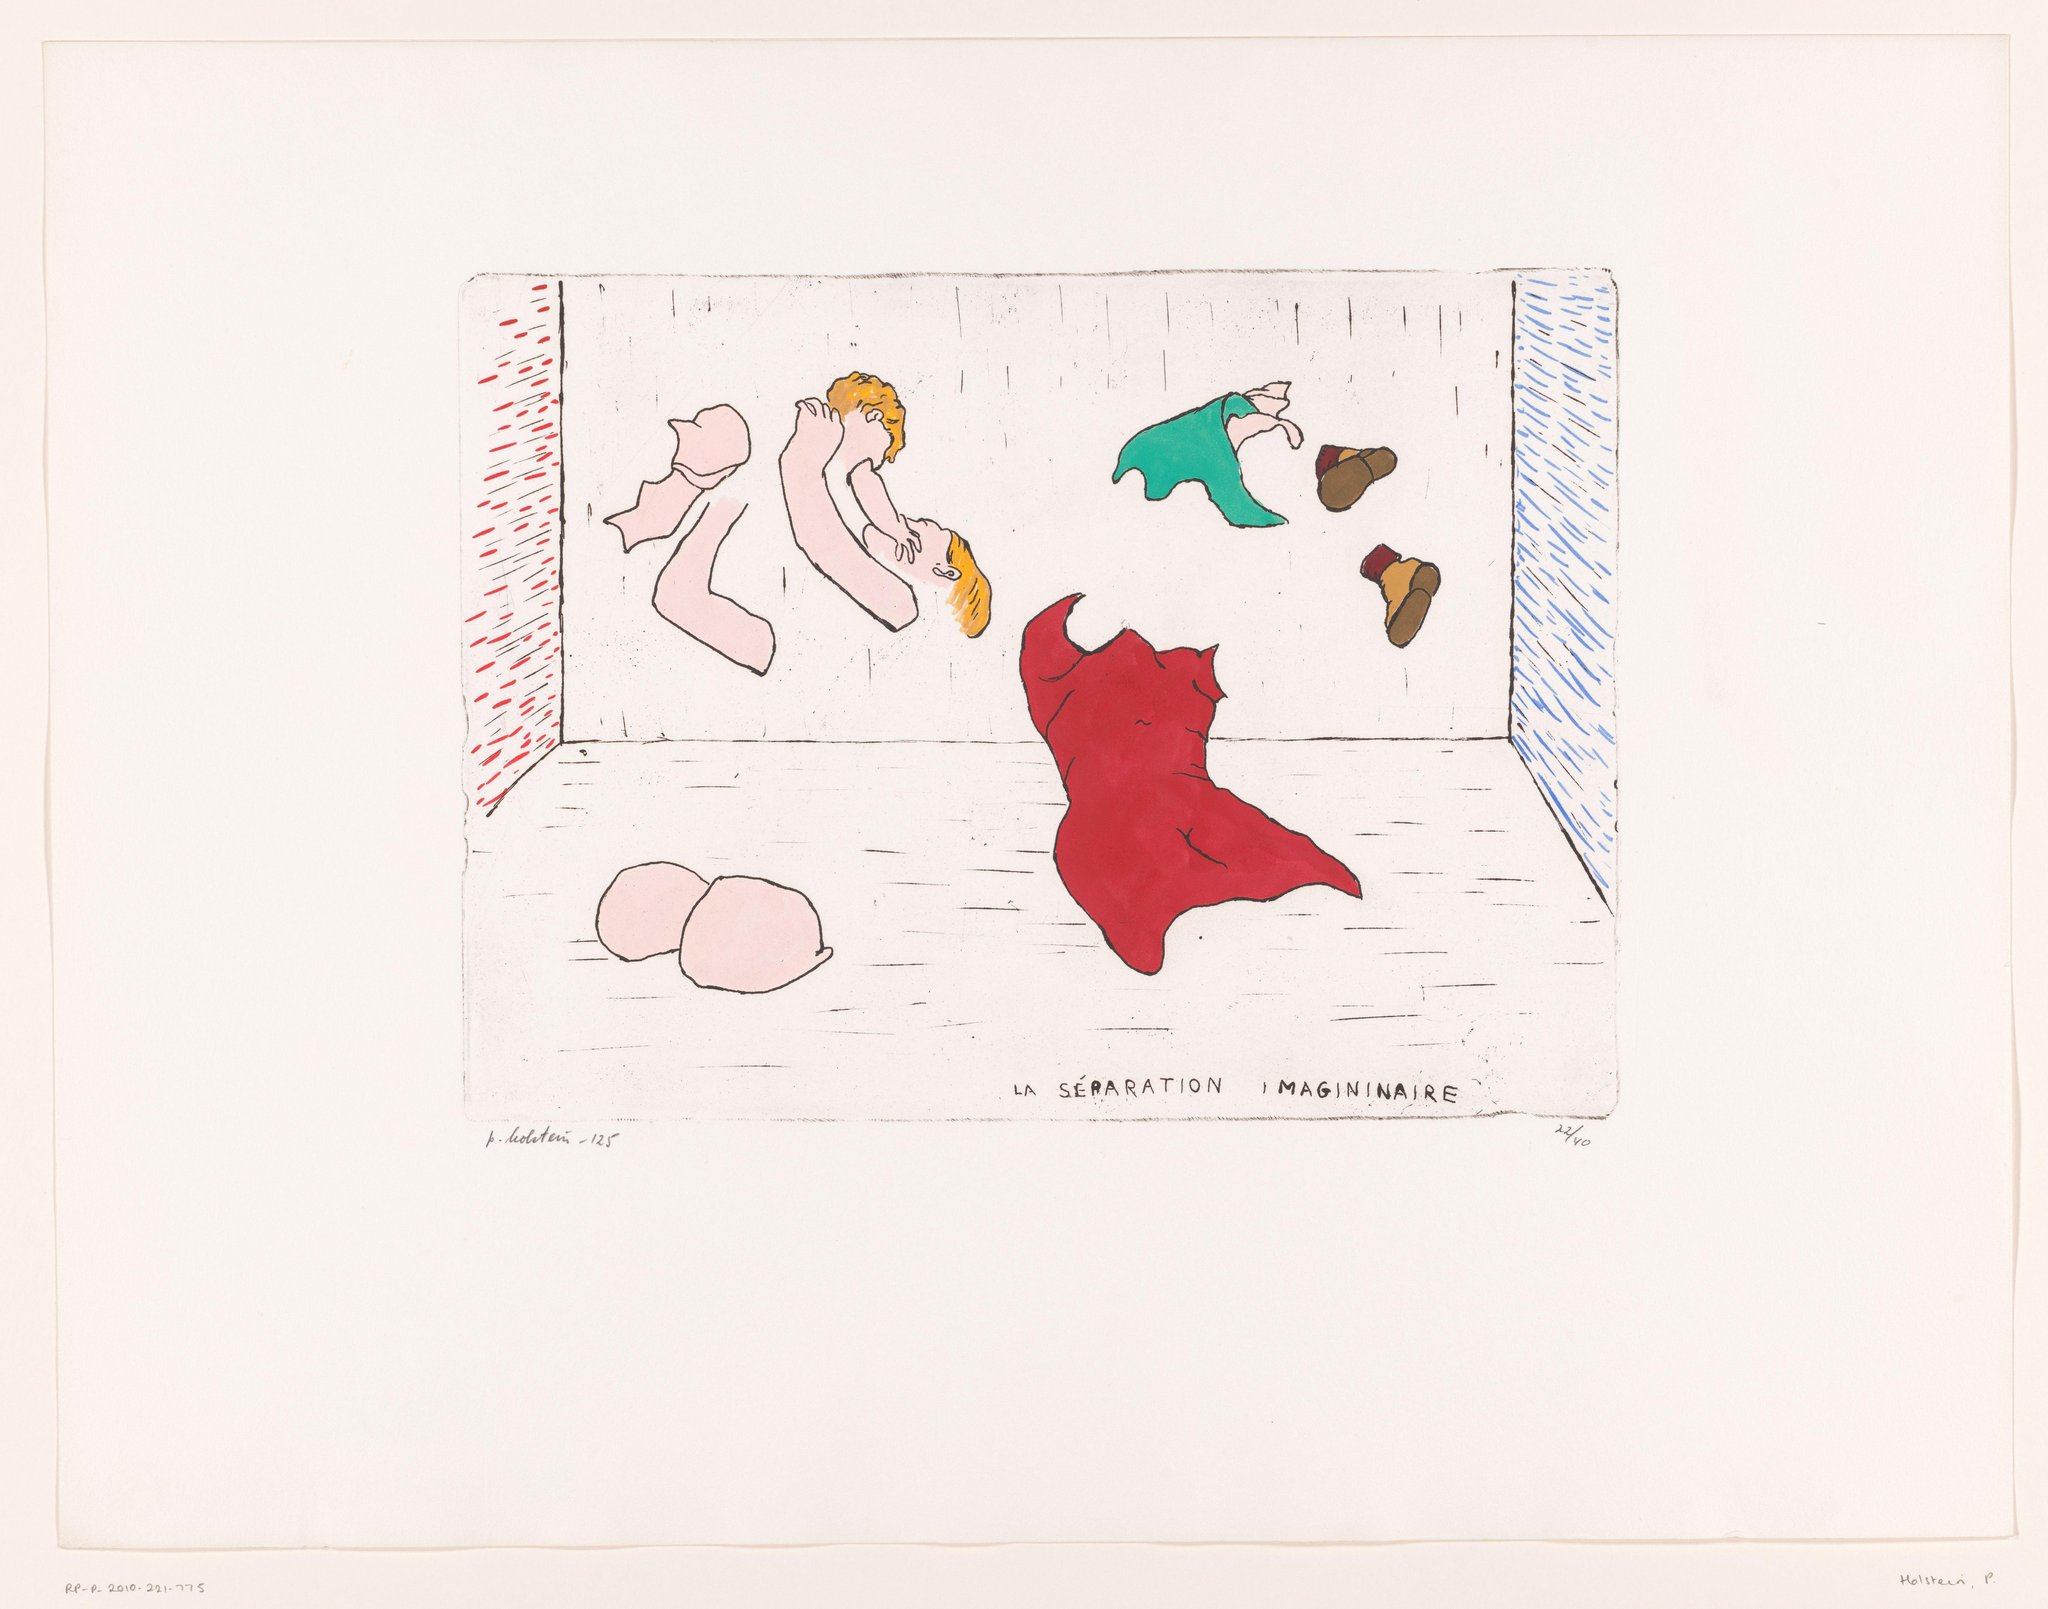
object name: print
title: La séparation imaginaire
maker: pieter holstein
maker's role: draughtsman, painter, print maker, sculptor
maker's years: 1934-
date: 1965-1972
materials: paper, watercolor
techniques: brush, etching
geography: amsterdam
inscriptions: signature: ‘p. holstein’, inscription: ‘125’, title: ‘LA SÉPARATION IMAGINAIRE’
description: Moeder en kind, gefragmenteerd weergegeven, met leegtes op de plekken waar hun kleding hoort te zitten, welke rechts van hen zwevend is afgebeeld.